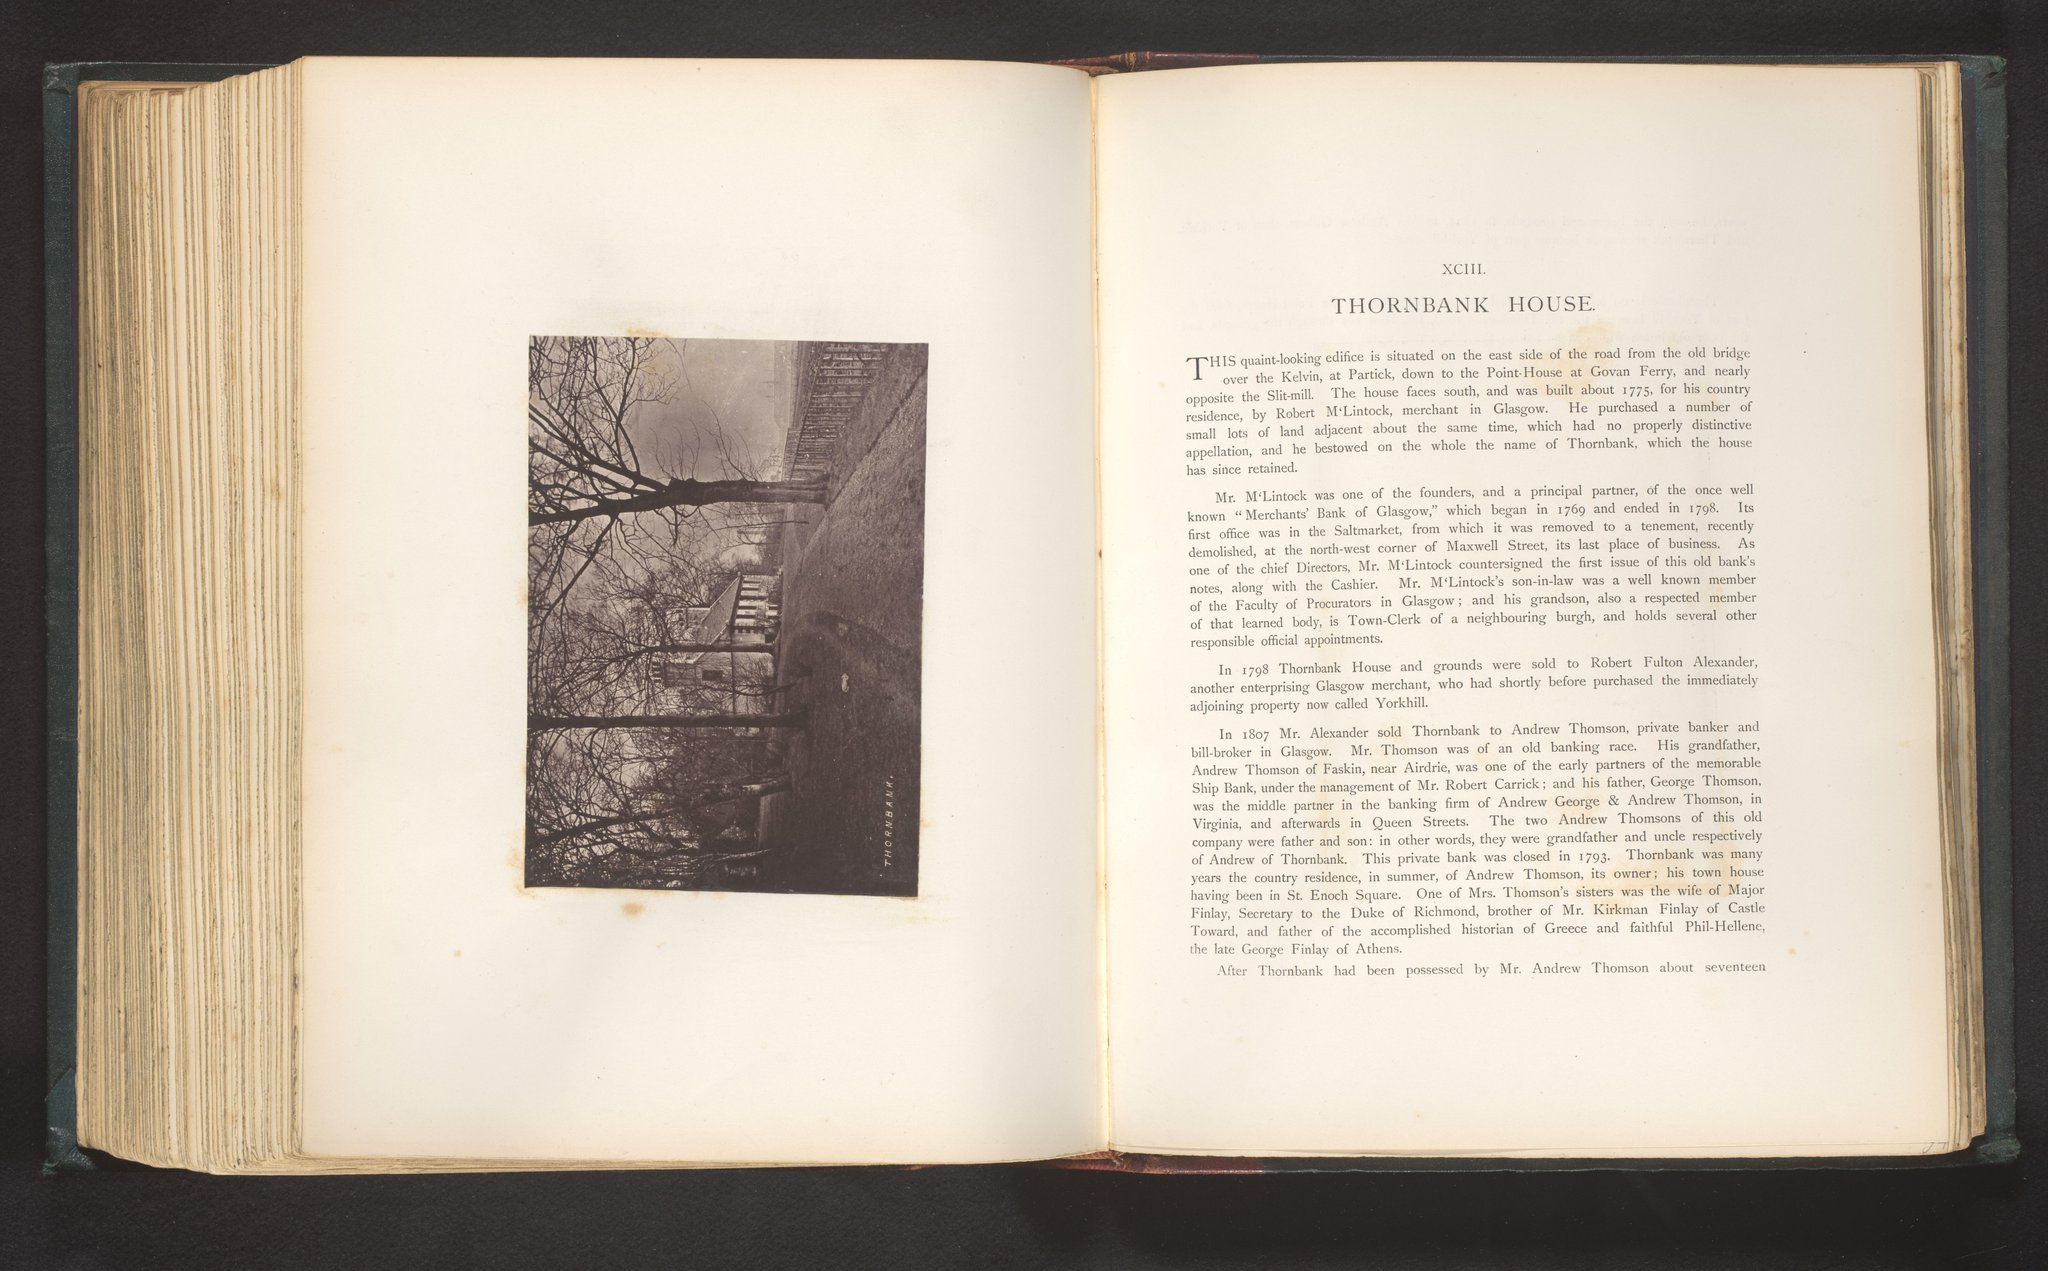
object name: page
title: Thornbank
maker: thomas annan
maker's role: fotograaf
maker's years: 1829-1887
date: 1868-1878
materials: paper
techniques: carbon print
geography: scotland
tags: rural housing, e.g. country-house, villa, cottage, façade (of house or building)